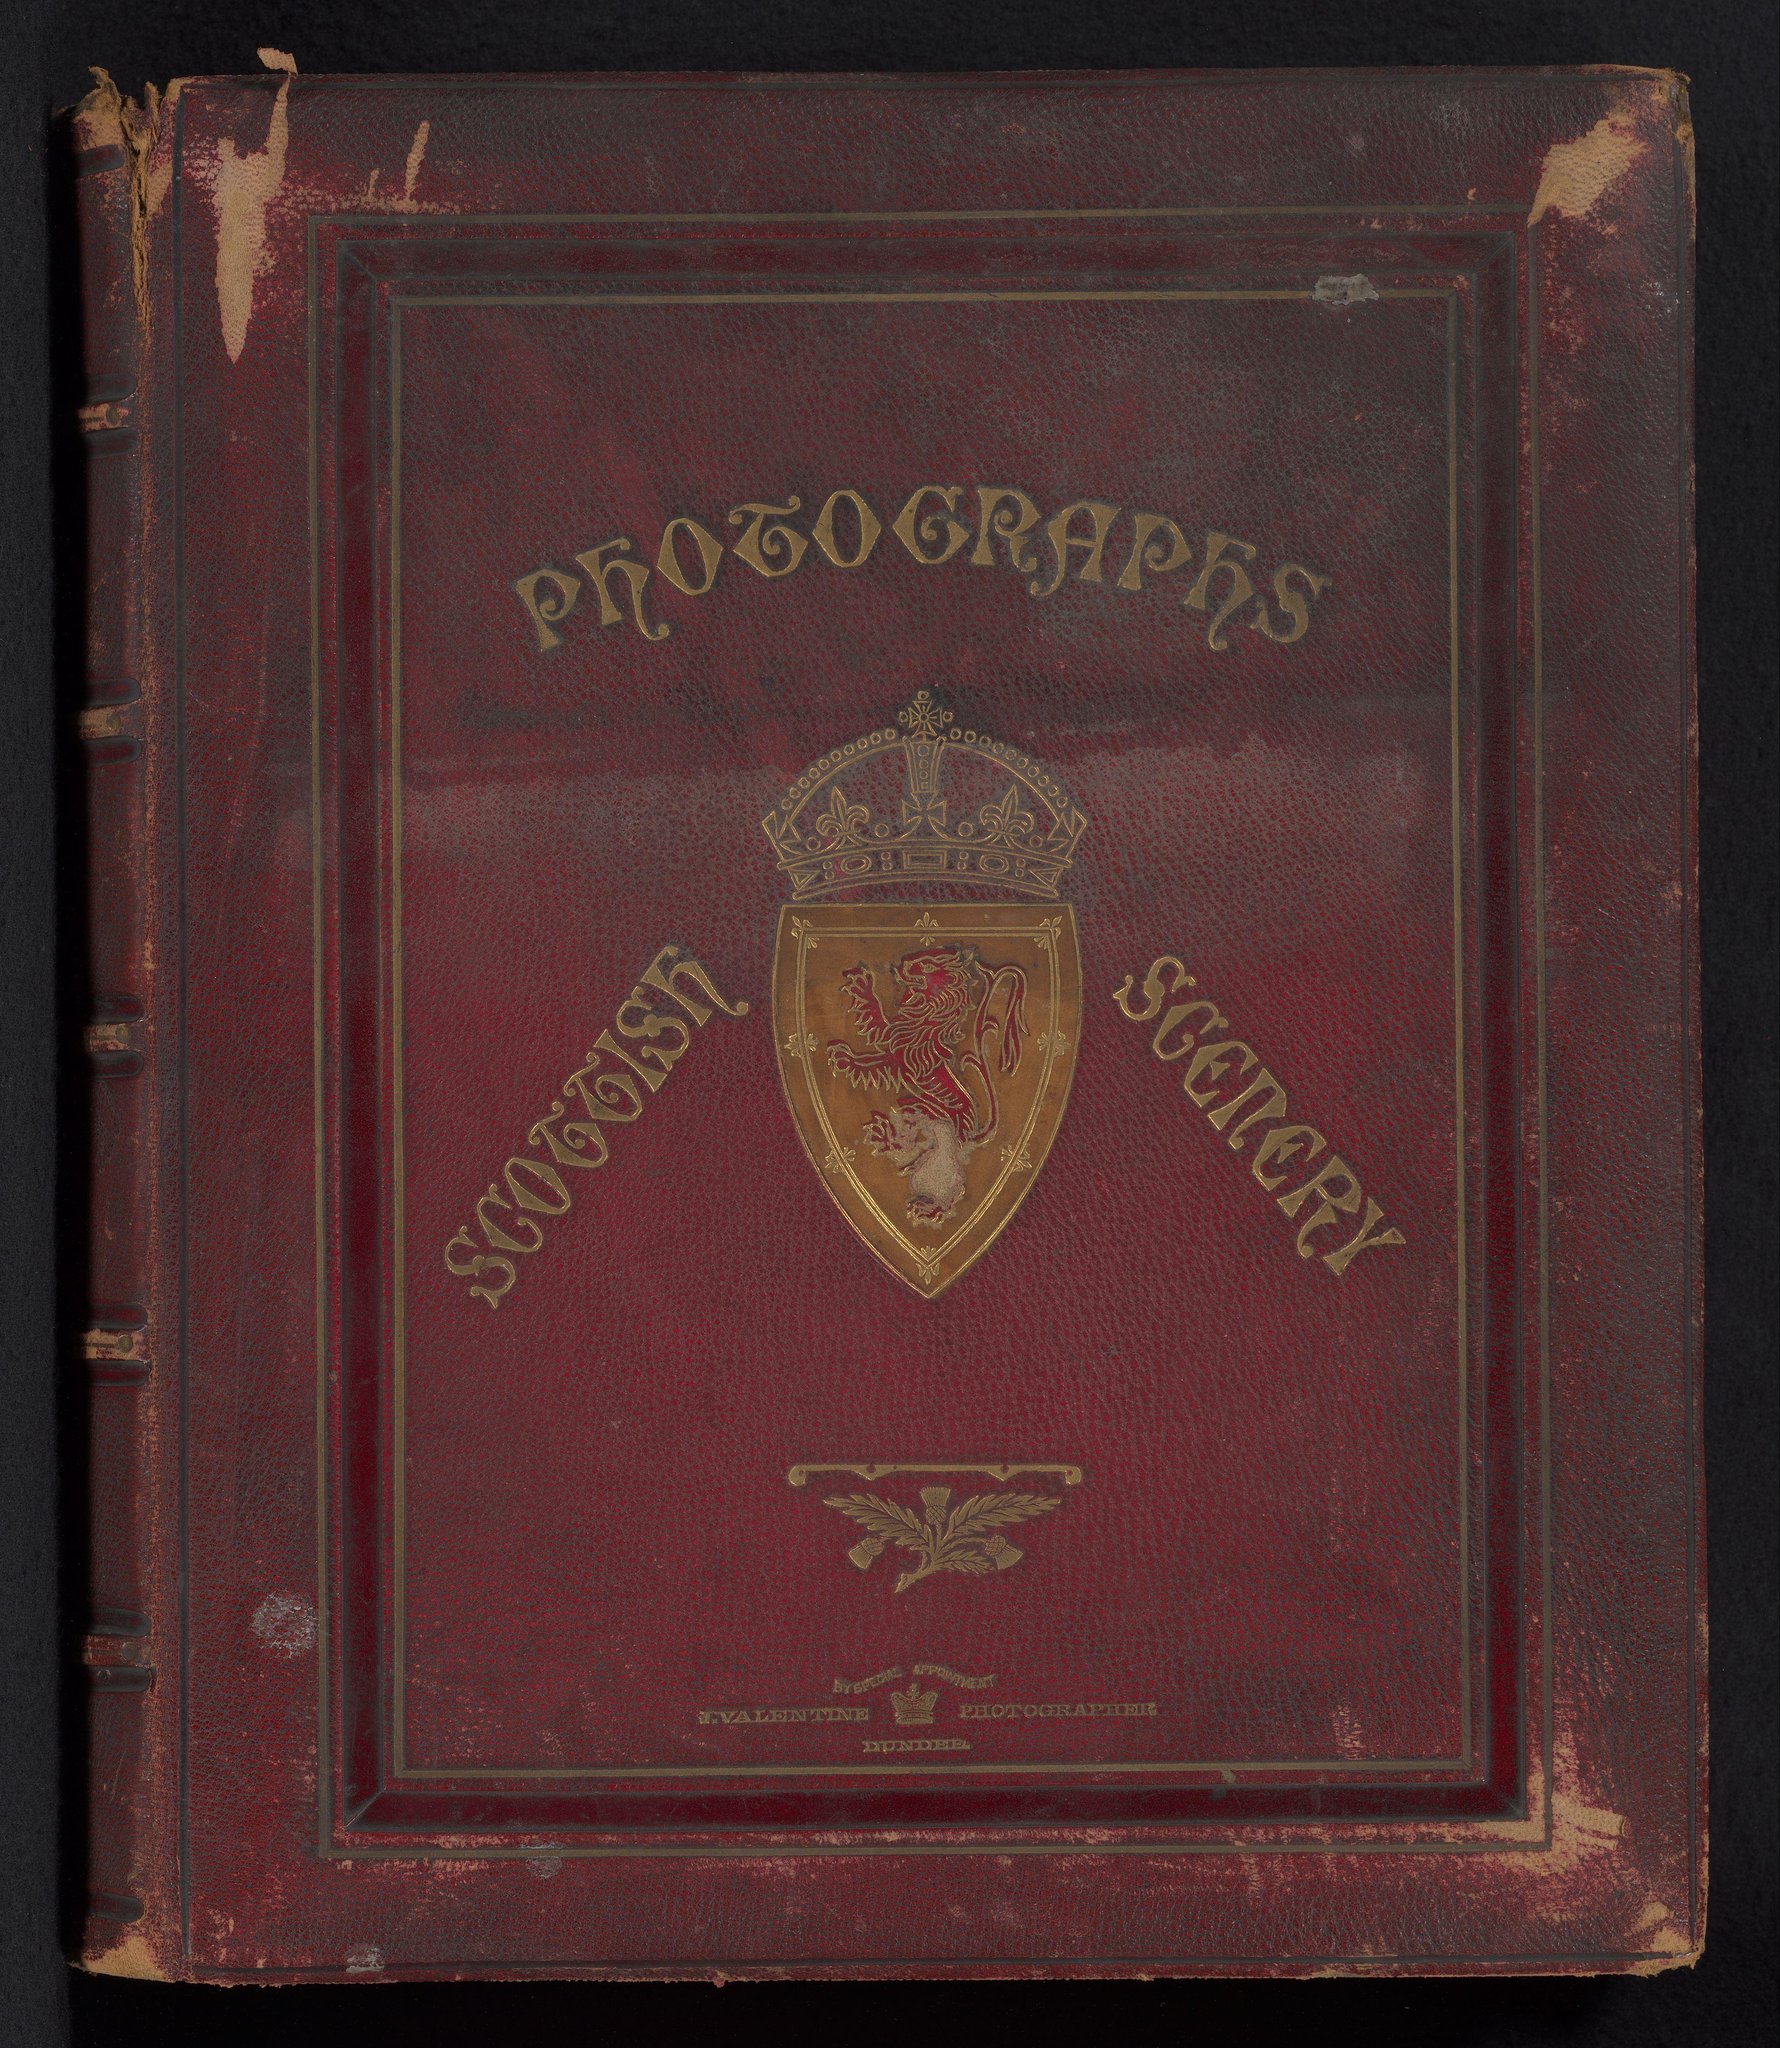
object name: scrapbook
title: Photographs Scottish Scenery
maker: Anonymous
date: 1875-1885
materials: cardboard, leather, paper, photographic support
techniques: albumen print, photograph, decorated paper, gelatin silver print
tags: city-view in general; 'veduta', castle, waterfall, landscapes with waters, waterscapes, seascapes (in the temperate zone), lake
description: Fotoalbum met 40 pagina's met 67 foto's van landschappen en steden in Schotland. Voorin het album zit één losse foto en één losse fotomechanische afdruk.